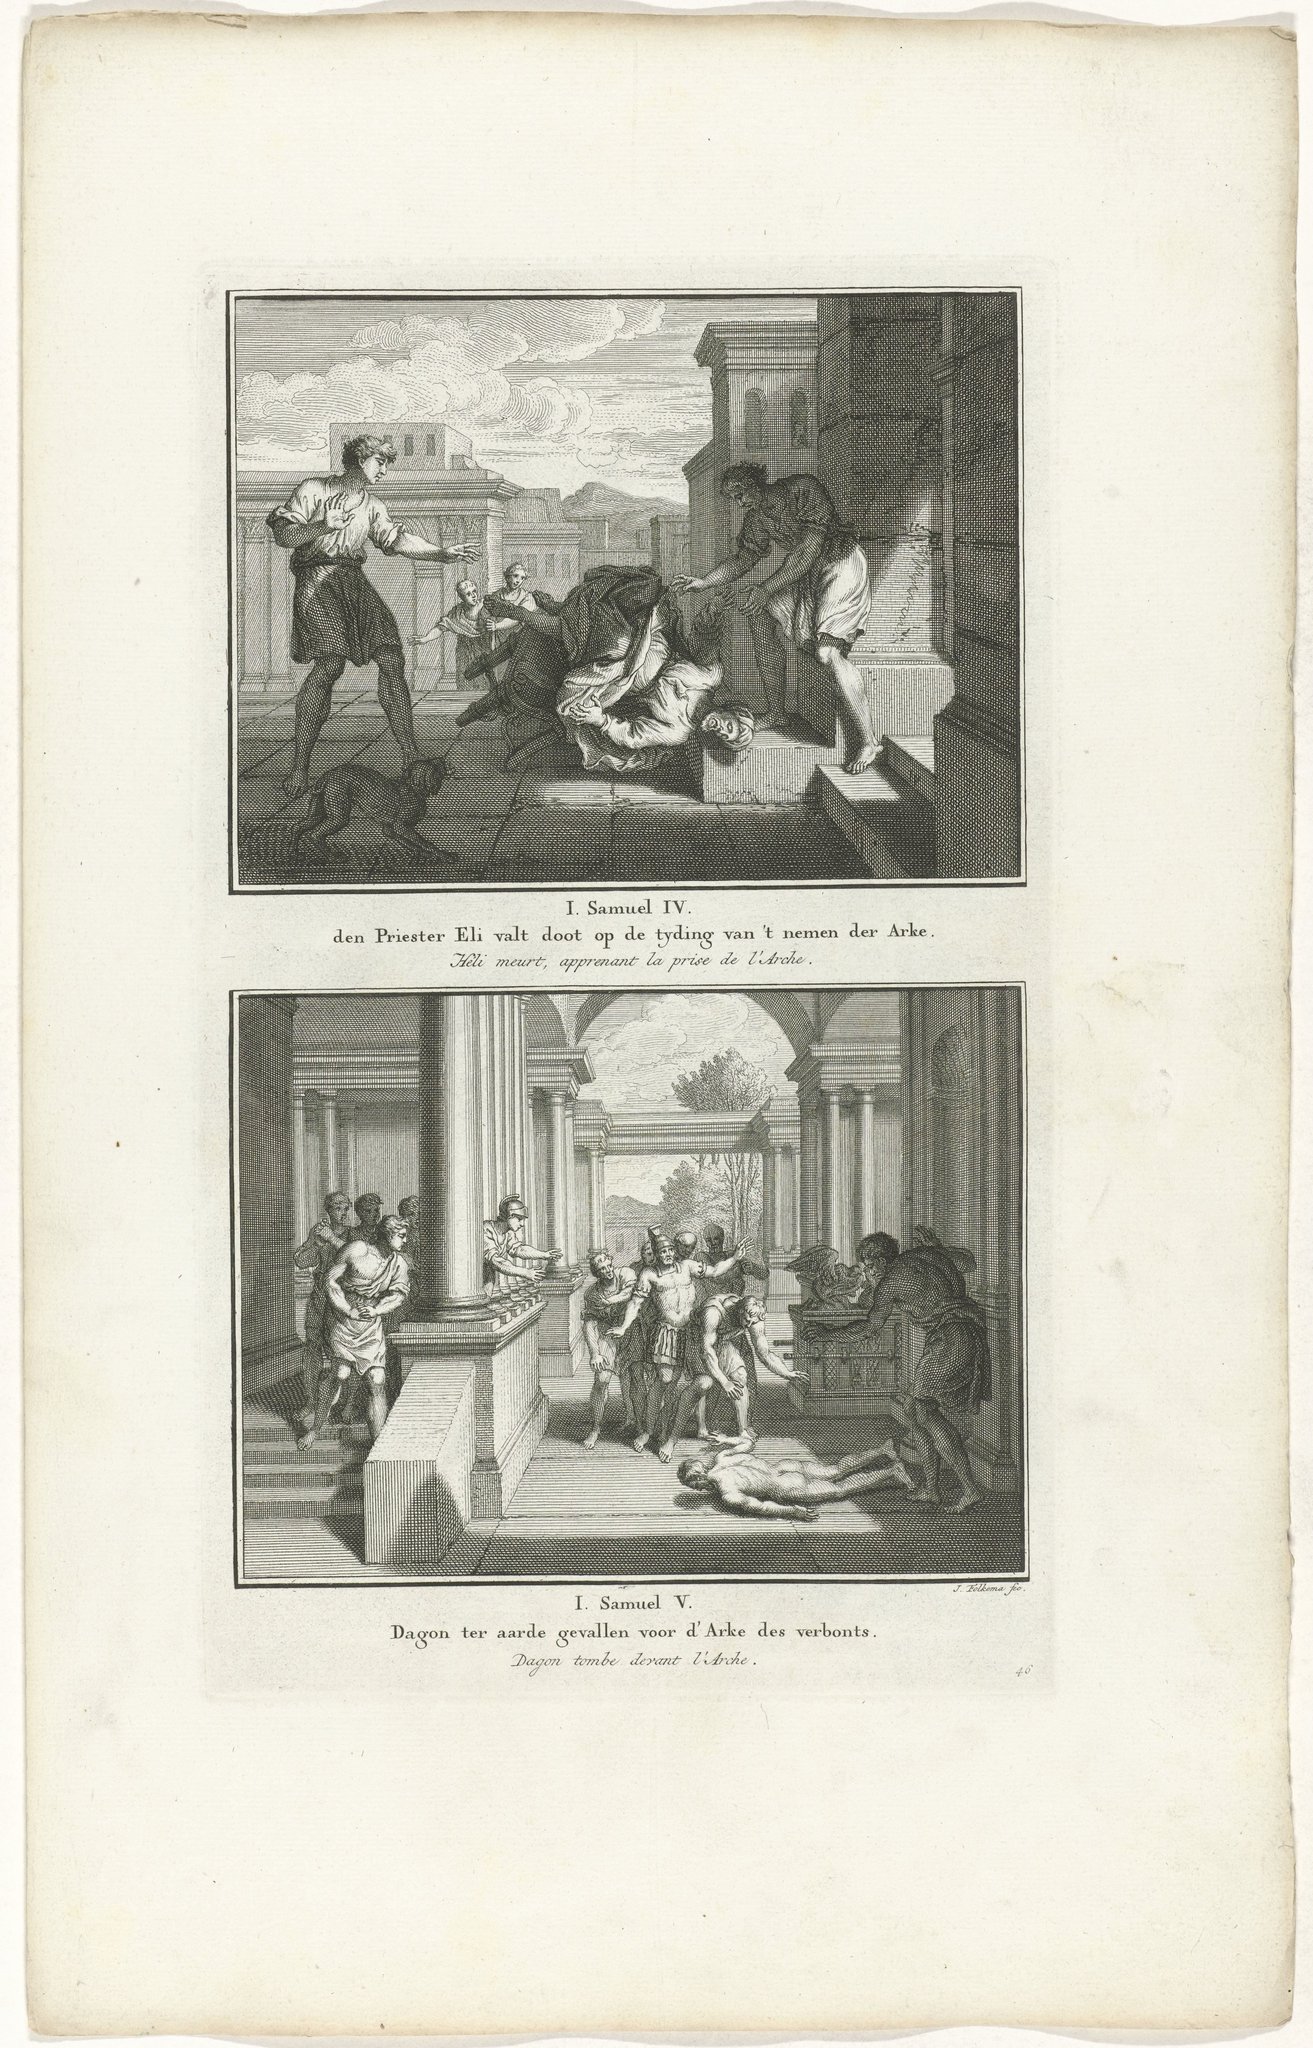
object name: print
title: Priester Eli valt van zijn stoel en het beeld Dagon valt ter aarde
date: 1791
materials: paper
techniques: etching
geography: amsterdam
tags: the statue of dagon in ashdod falls down, eli, hearing of the capture of the ark, falls from his seat and dies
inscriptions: collector's mark, collector's mark: Lugt 2233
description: Twee Bijbelse voorstellingen uit 1 Sam. 4 en 5. Priester Eli valt van zijn stoel en sterft wanneer hij hoort dat de Ark des Verbonds is ingenomen, en het beeld Dagon valt ter aarde naast de Ark des Verbonds. Twee voorstellingen van één plaat, elk voorzien van een titel in het Nederlands en Frans. Geheel rechtsonder genummerd: 46.